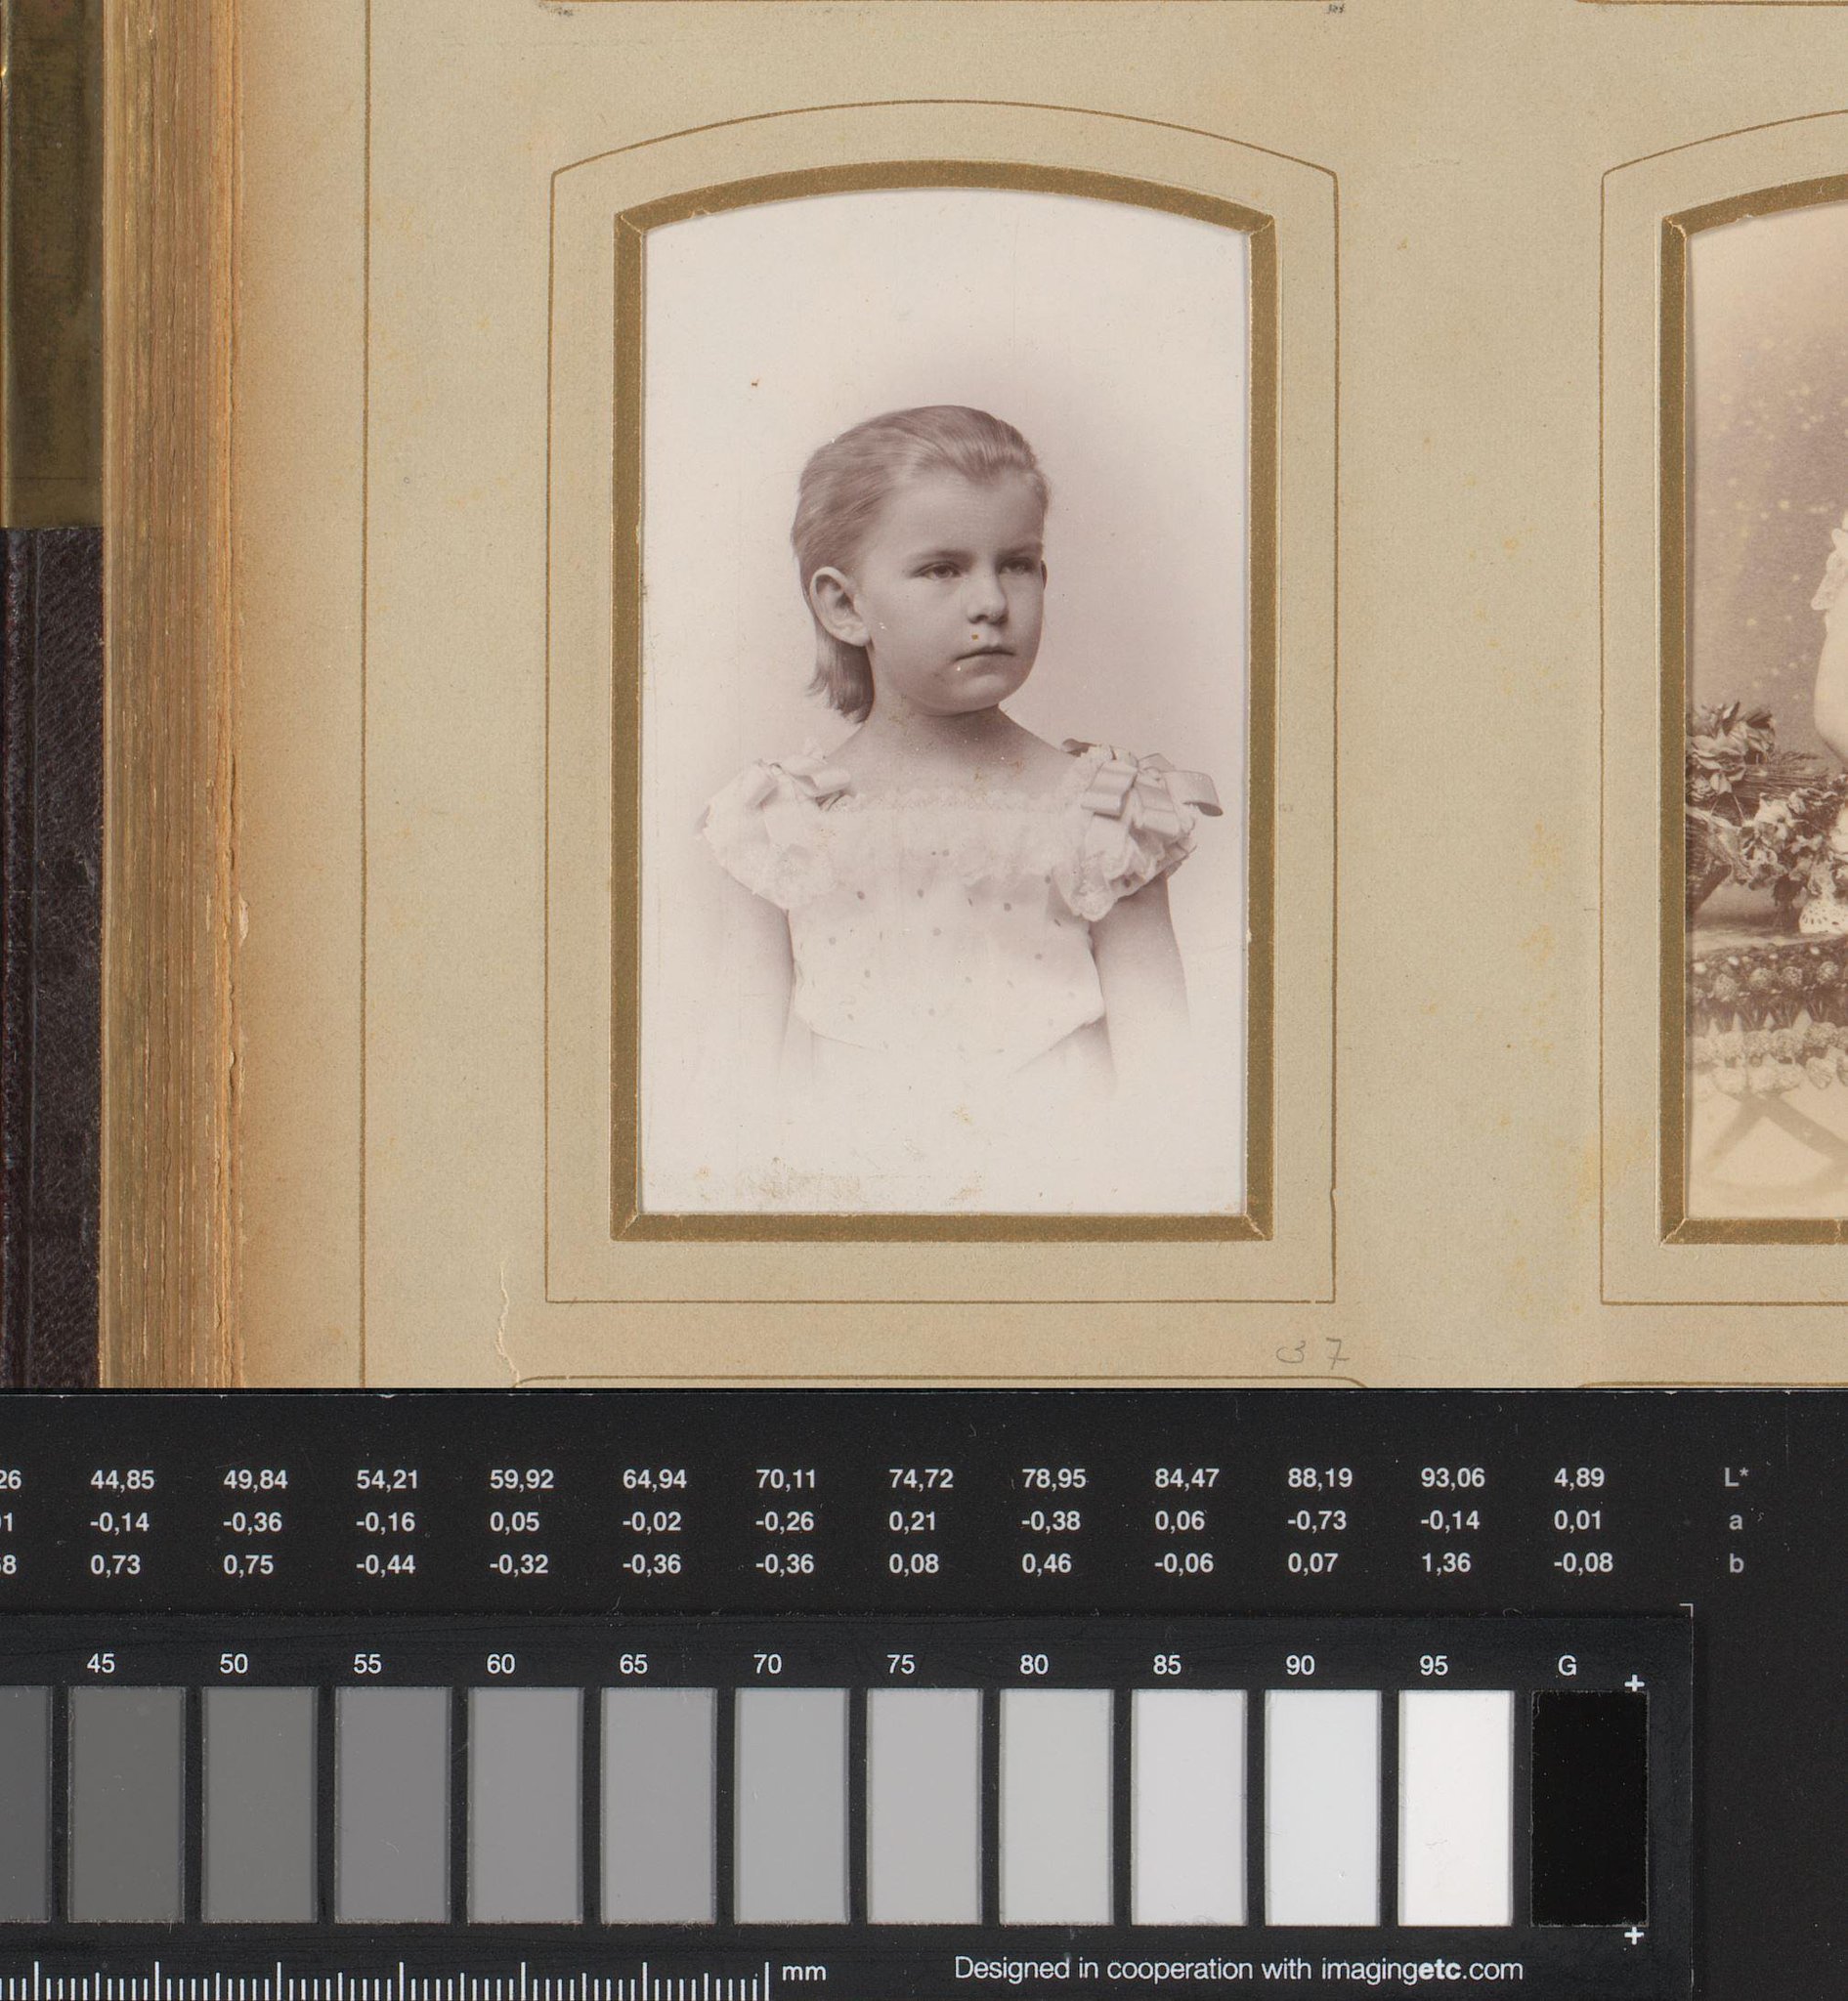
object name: photograph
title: Studioportret van Margo Kessler op jeugdige leeftijd in een wit jurkje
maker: kameke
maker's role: painter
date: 1891-1895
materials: paper, photographic support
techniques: photography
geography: amsterdam